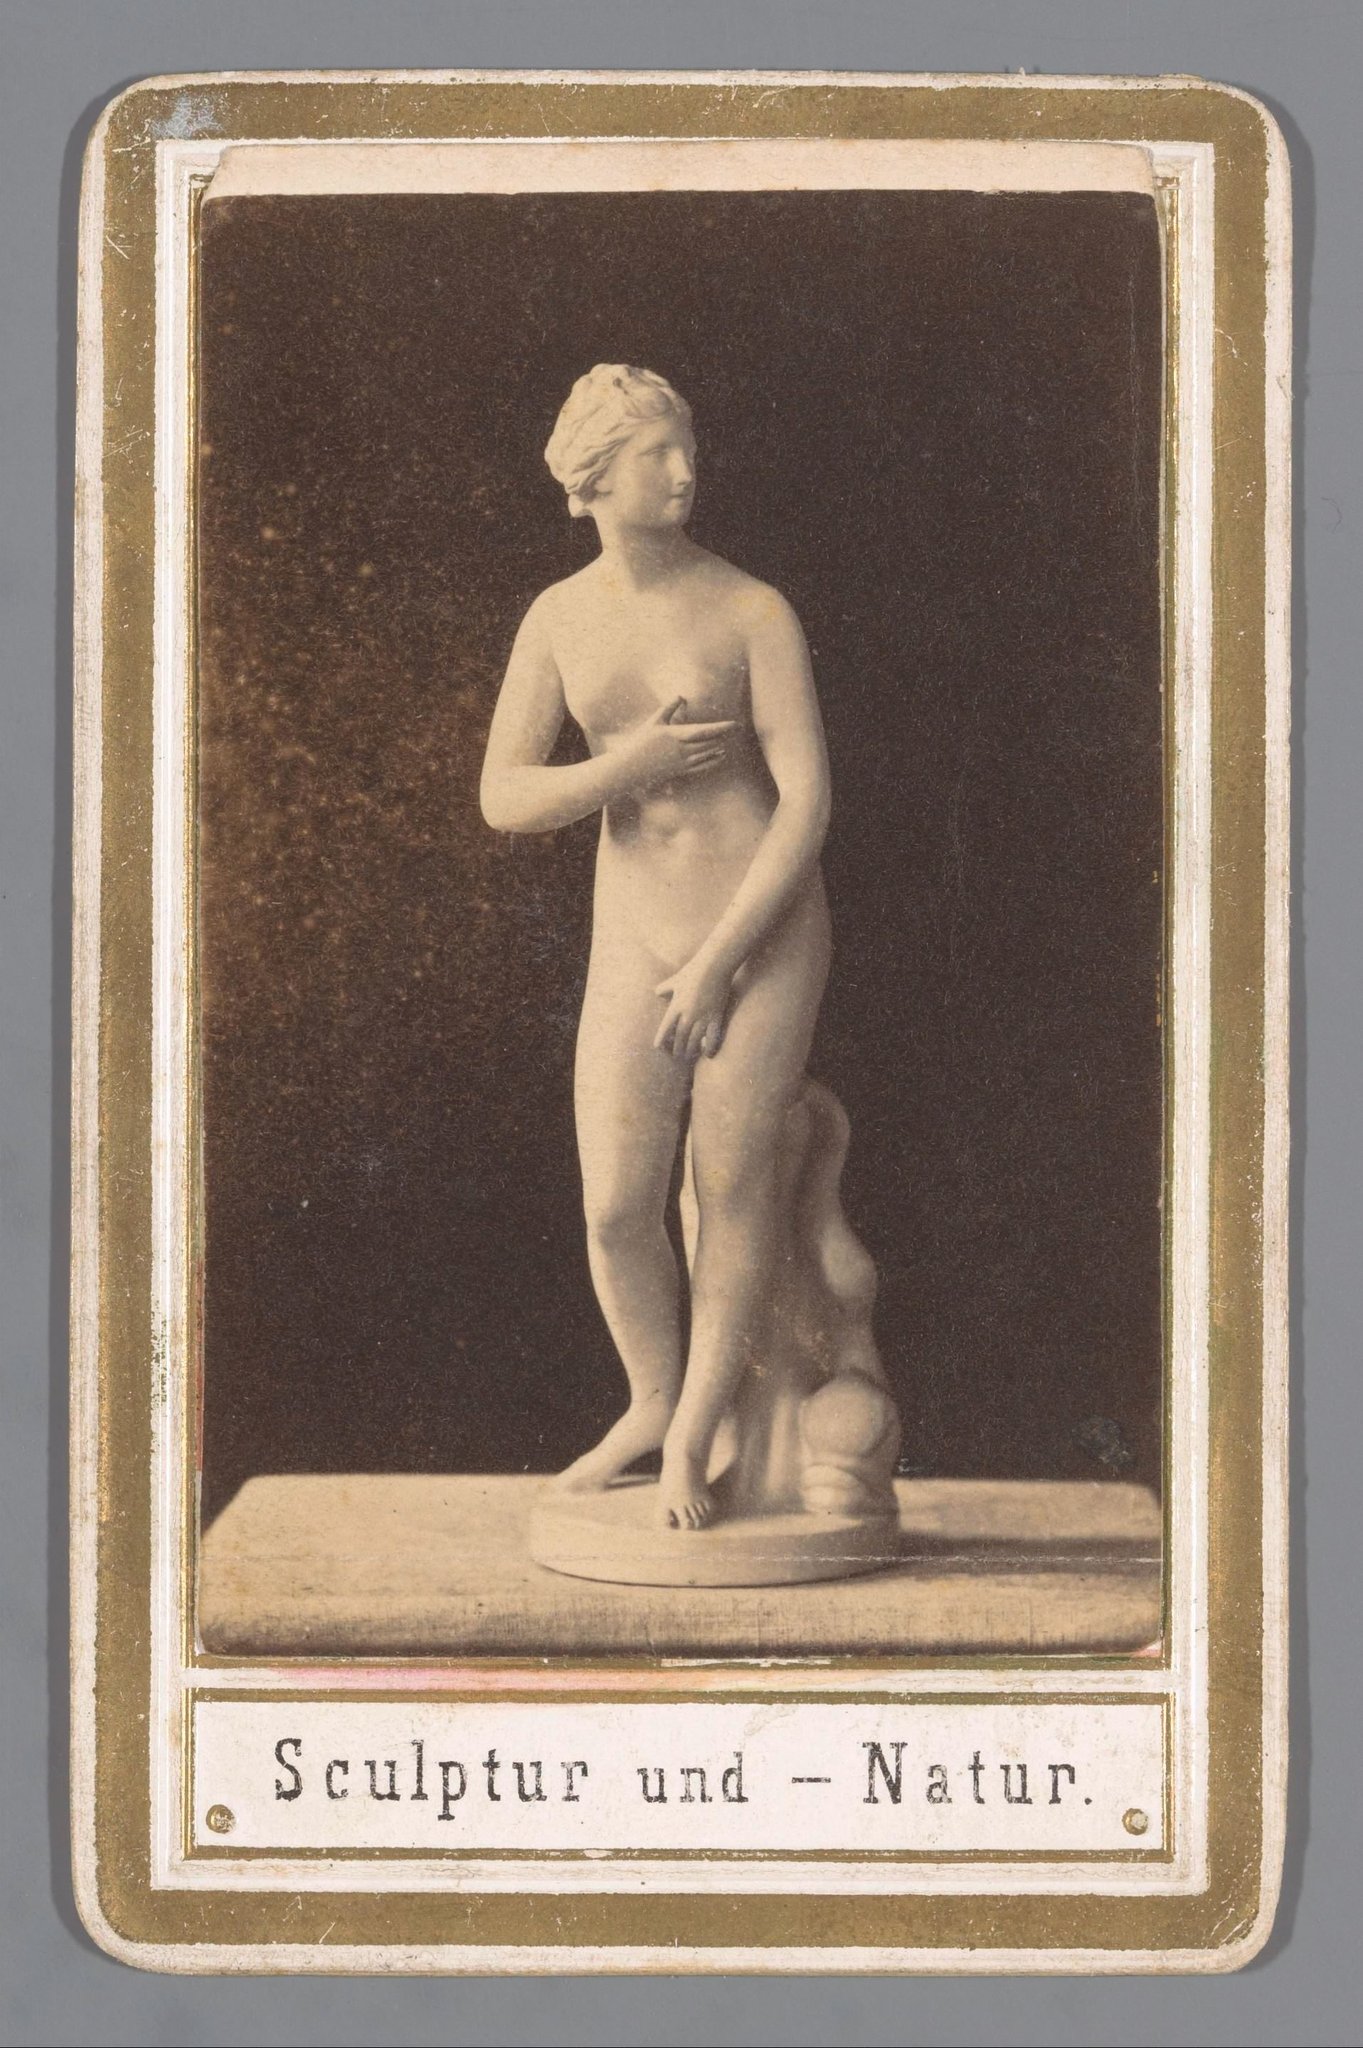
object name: carte de visite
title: Sculptuur van Venus Medici, met achter de foto een voorstelling van een half ontklede vrouw in dezelfde houding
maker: Anonymous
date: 1870-1900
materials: cardboard, paper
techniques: albumen print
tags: piece of sculpture, reproduction of a piece of sculpture, (story of) venus (aphrodite)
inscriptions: inscription: ‘Venus von Medicis. / (Antik.) / Grade wie ein Blitzableiter / Steht sie dort - mit holden Mienen, / Könnt' sie doch im neuen Jahre / Dir, o Freund, als solcher dienen.’